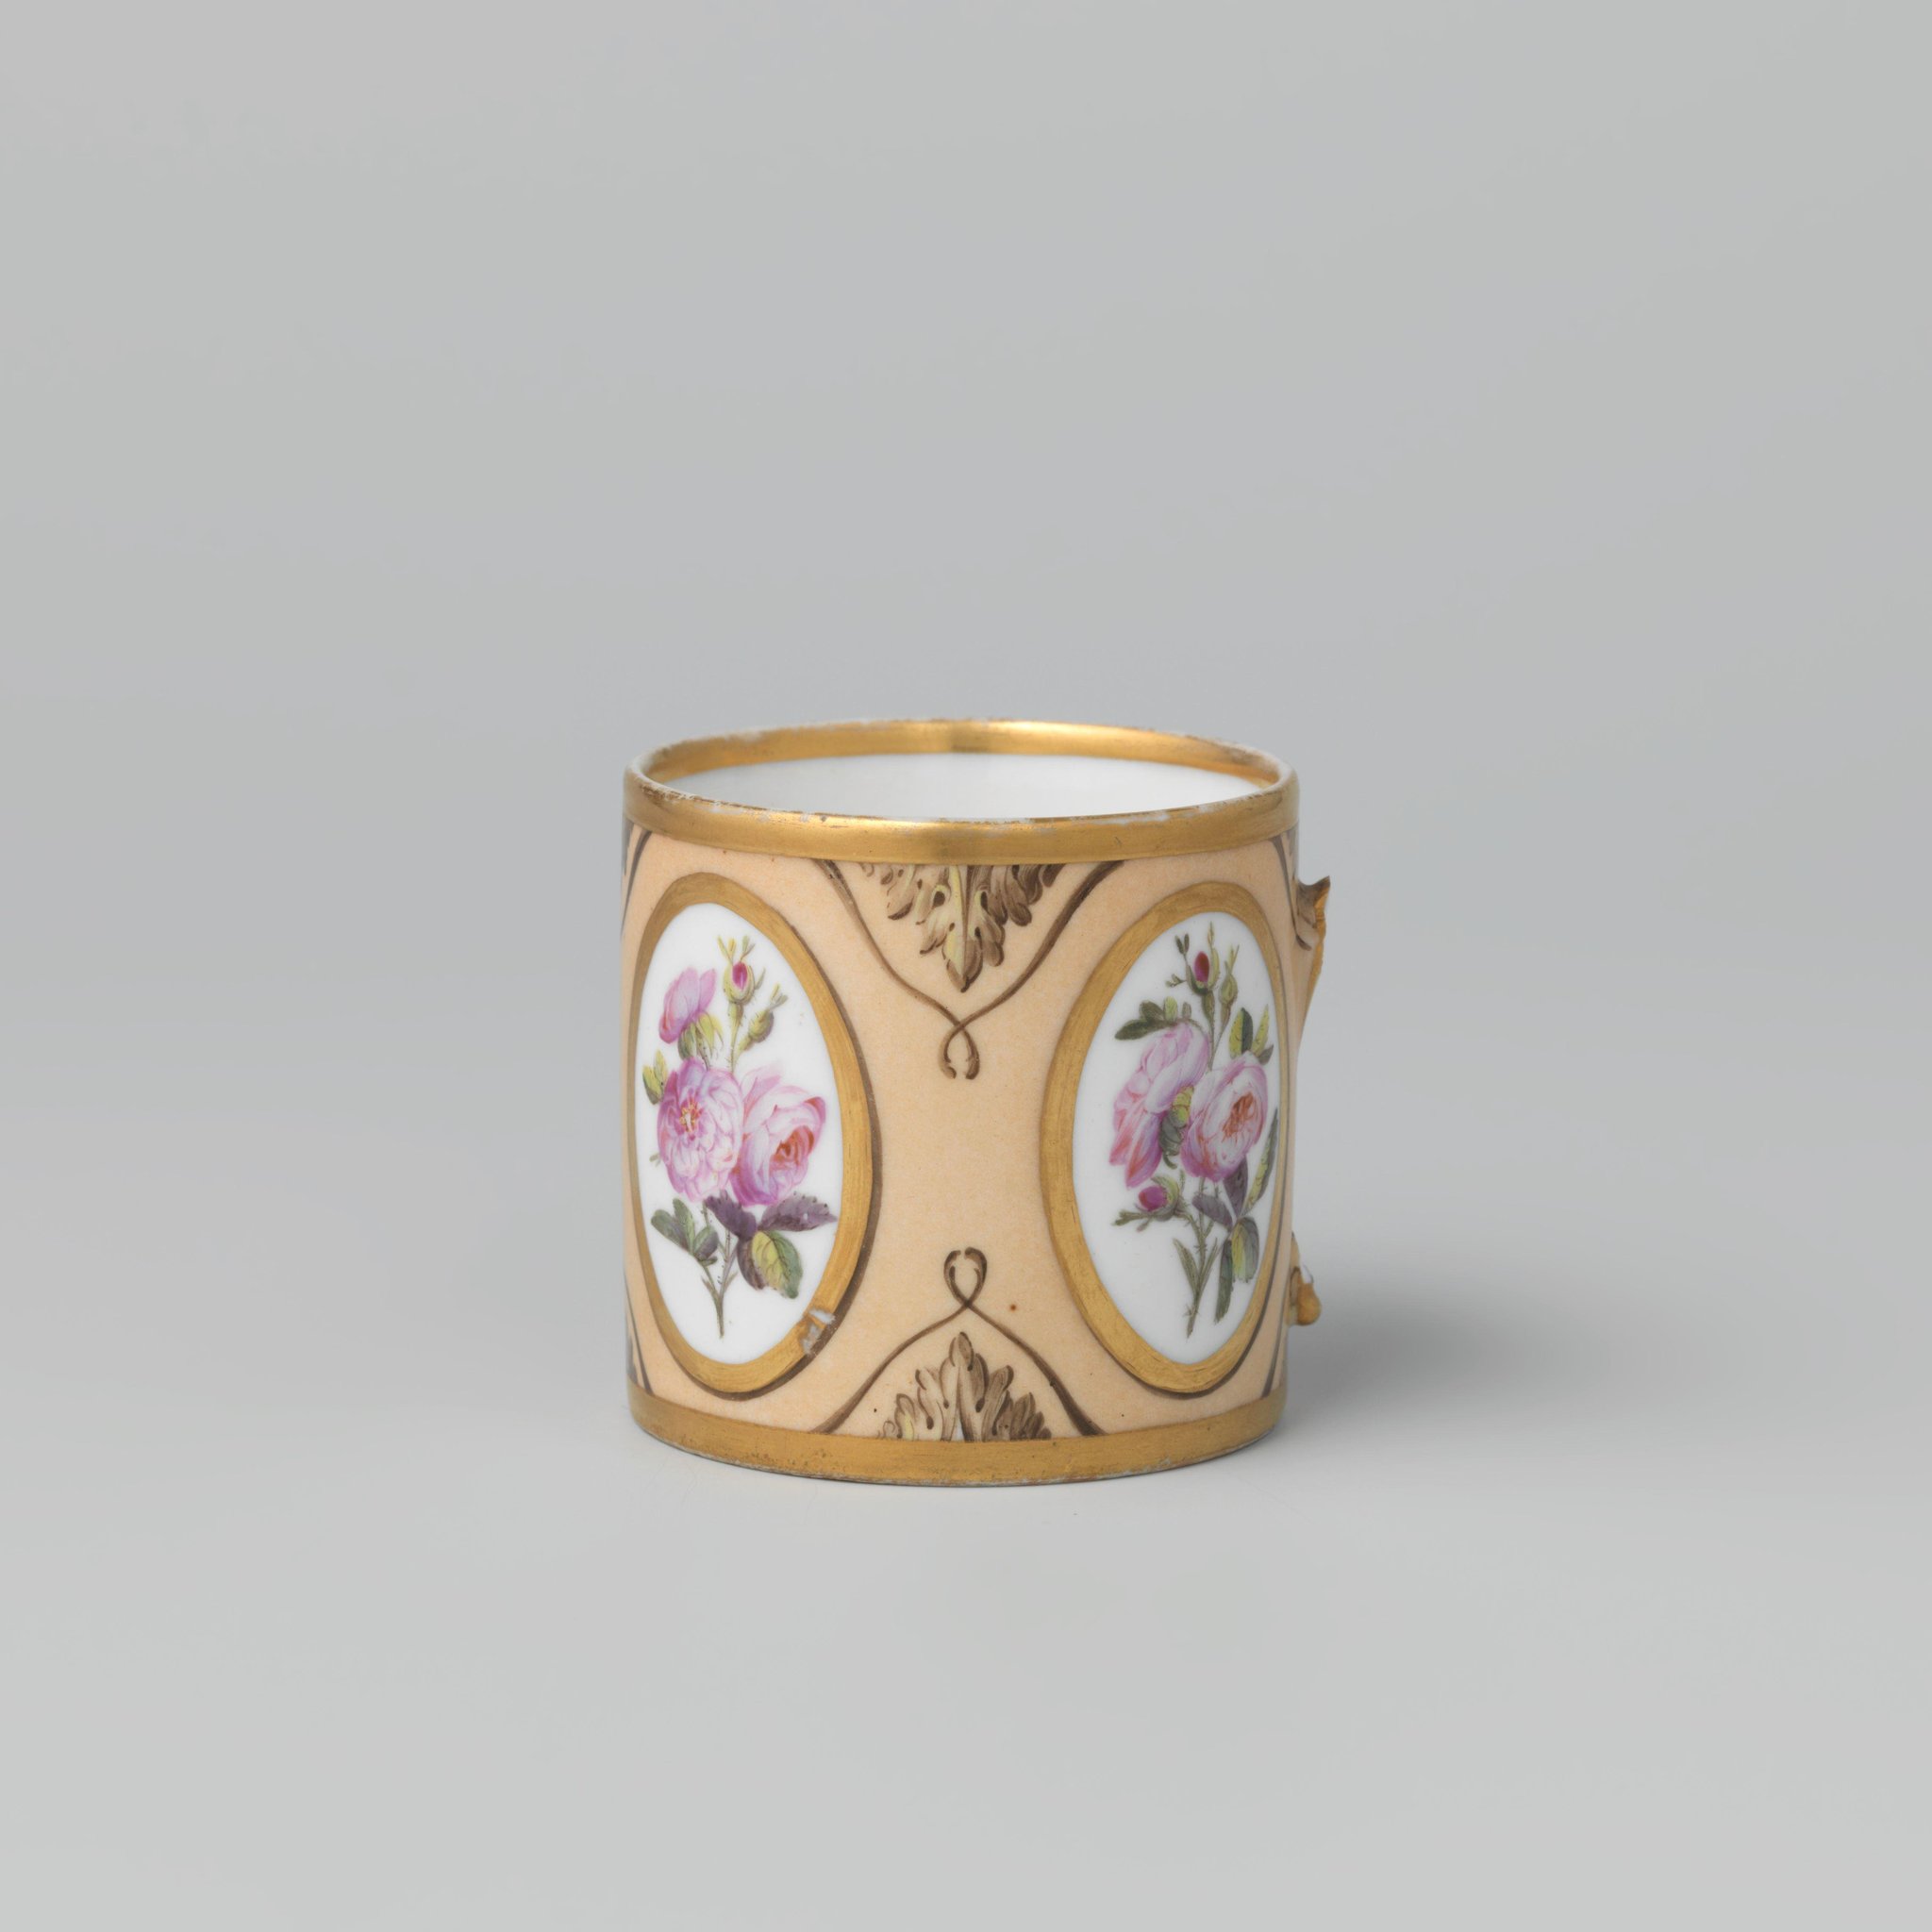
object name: cup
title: Cup with roses in medallions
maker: Anonymous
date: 1800-1810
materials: glaze, gold, paint, porcelain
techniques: forming, gilding, turning, vitrification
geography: france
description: Kop van porselein met een cilindrische wand, beschilderd op het glazuur in emailkleuren en goud. De buitenwand is bedekt met een crèmekleurig glazuur met daarin uitgespaard vier ovale medaillons met pioenrozen. Hiertussen afhangende en staande bladmotieven. Gouden band boven de voet en op de rand. Oor ontbreekt.